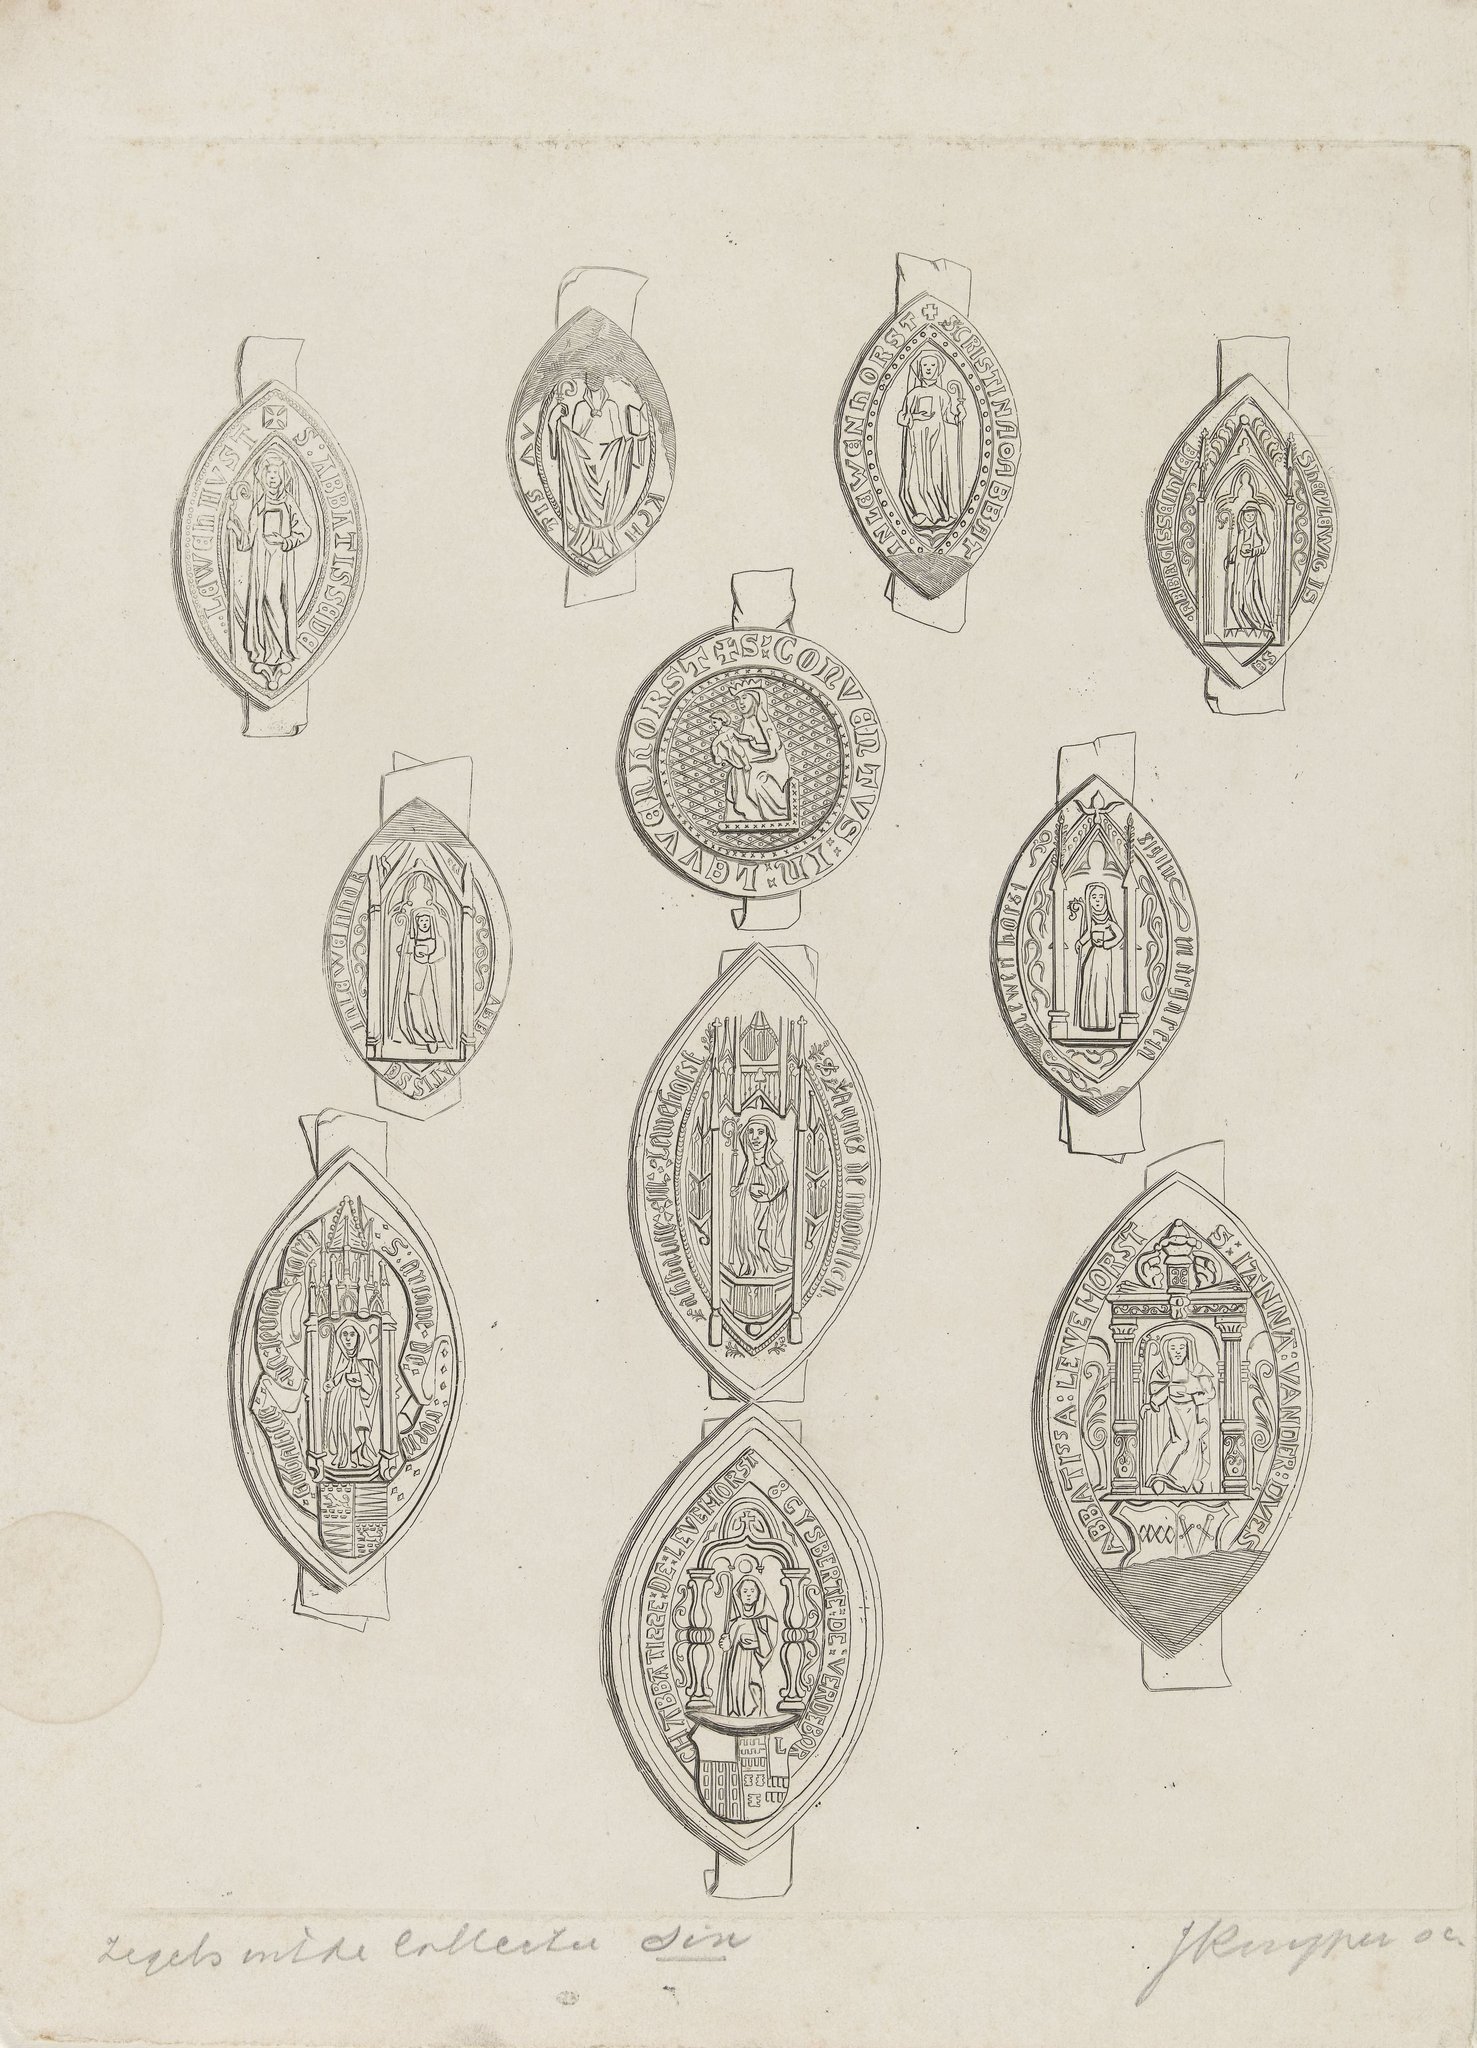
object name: print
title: Elf zegels uit de collectie Six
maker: j. kuyper (prentmaker)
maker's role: print maker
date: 1860-1870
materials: paper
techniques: etching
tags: seal, stamp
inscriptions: collector's mark: Lugt 2228, inscription: ‘Zegels uit de collectie Six J Kuyper [...]’